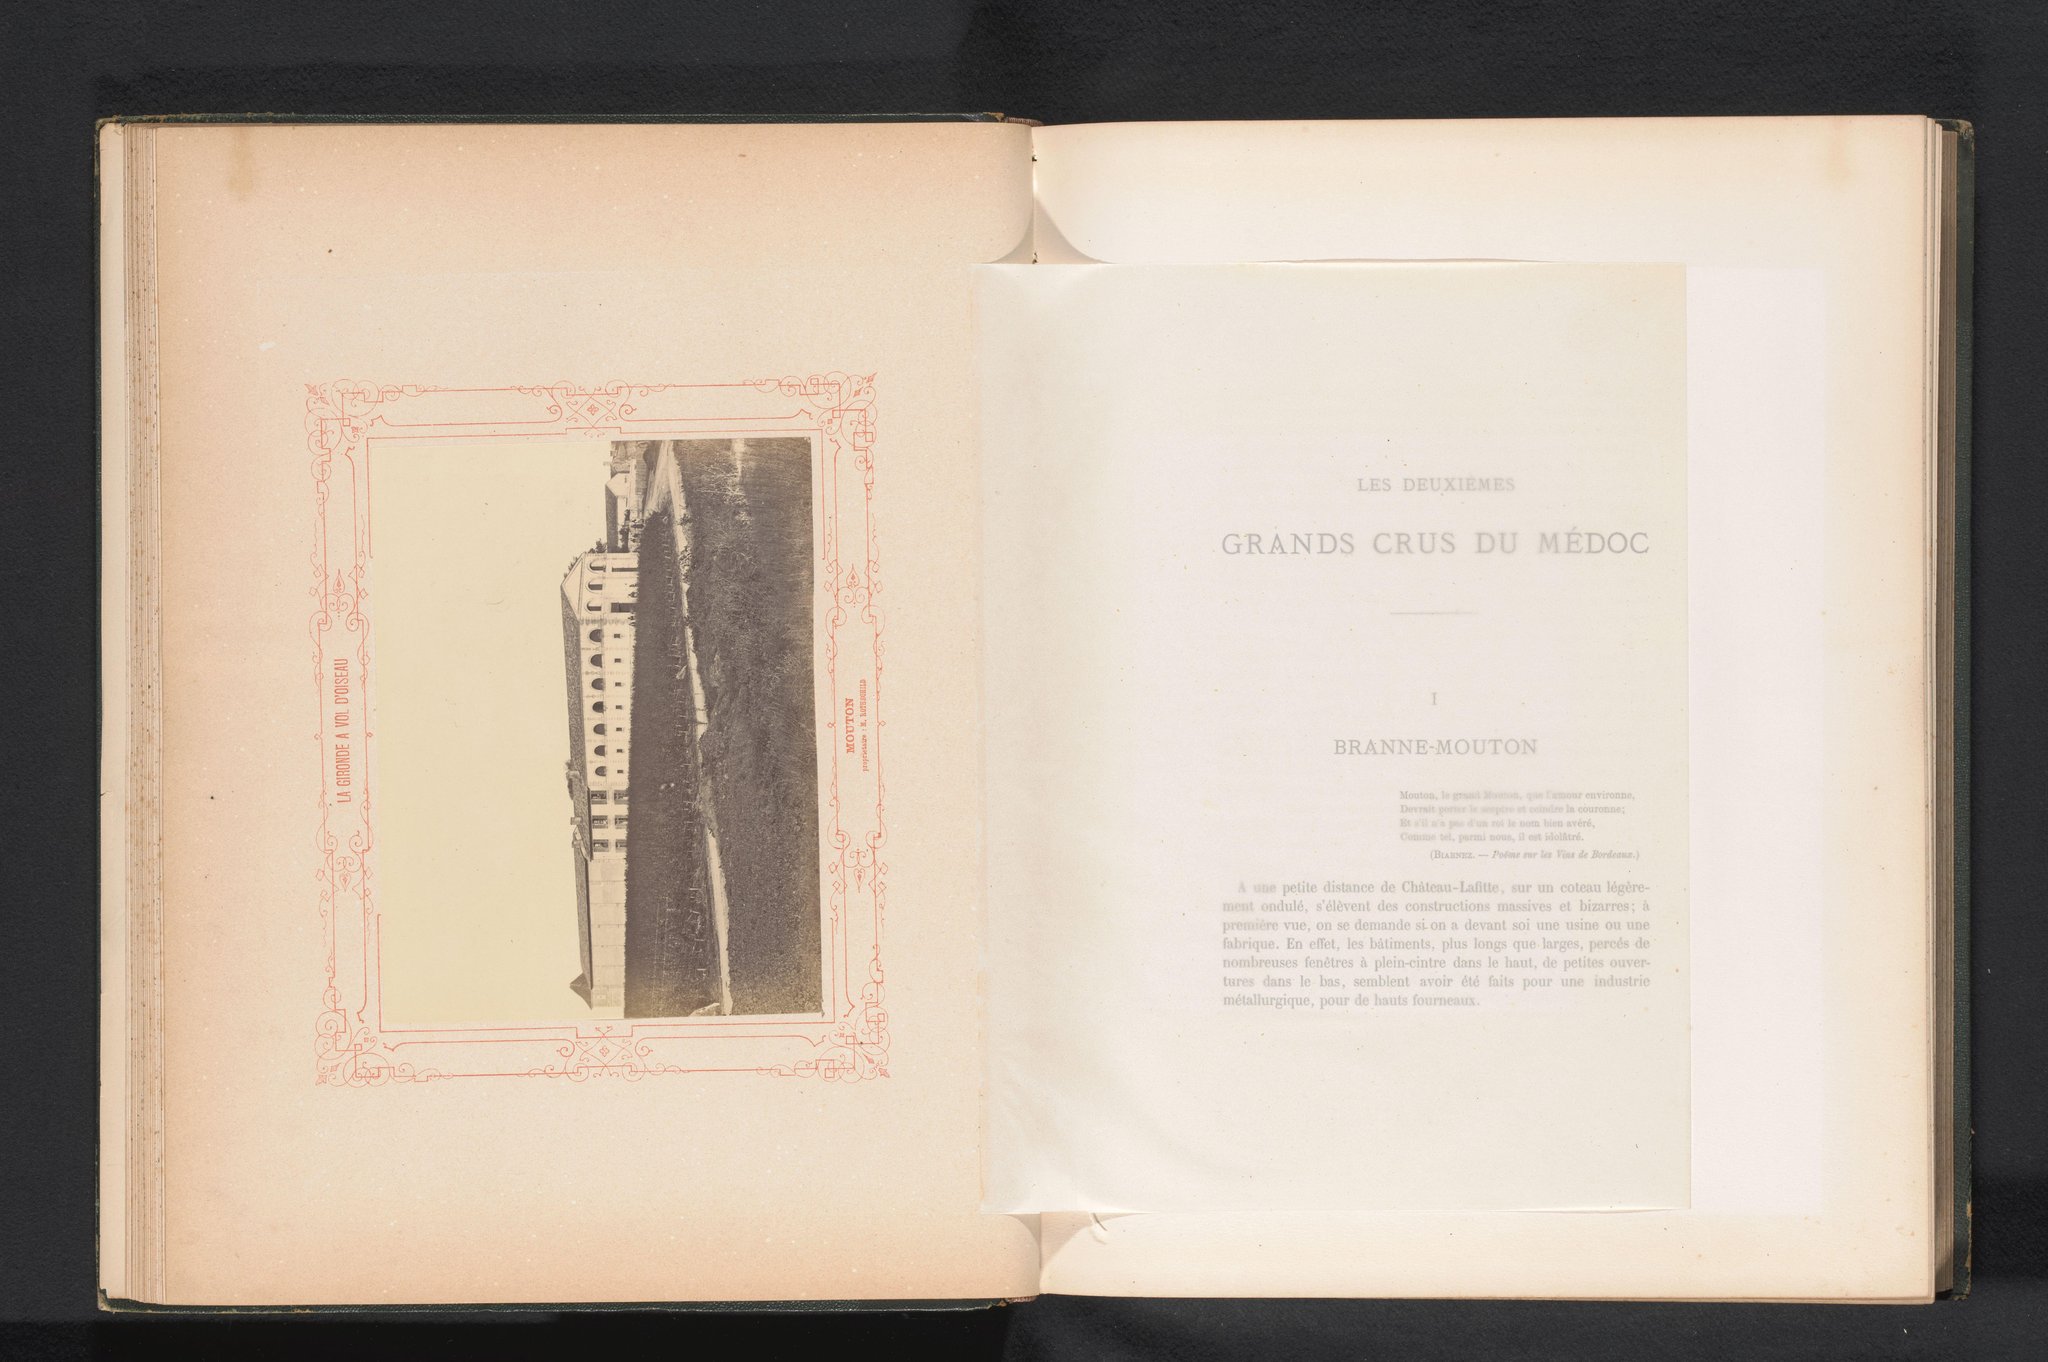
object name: photograph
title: Gezicht op Château Mouton-Rothschild in Pauillac, Frankrijk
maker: alfred danflou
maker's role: fotograaf, schrijver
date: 1862-1867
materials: photographic support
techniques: albumen print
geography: pauillac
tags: castle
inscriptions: inscription: ‘propriétaire: M. Rothschild.’